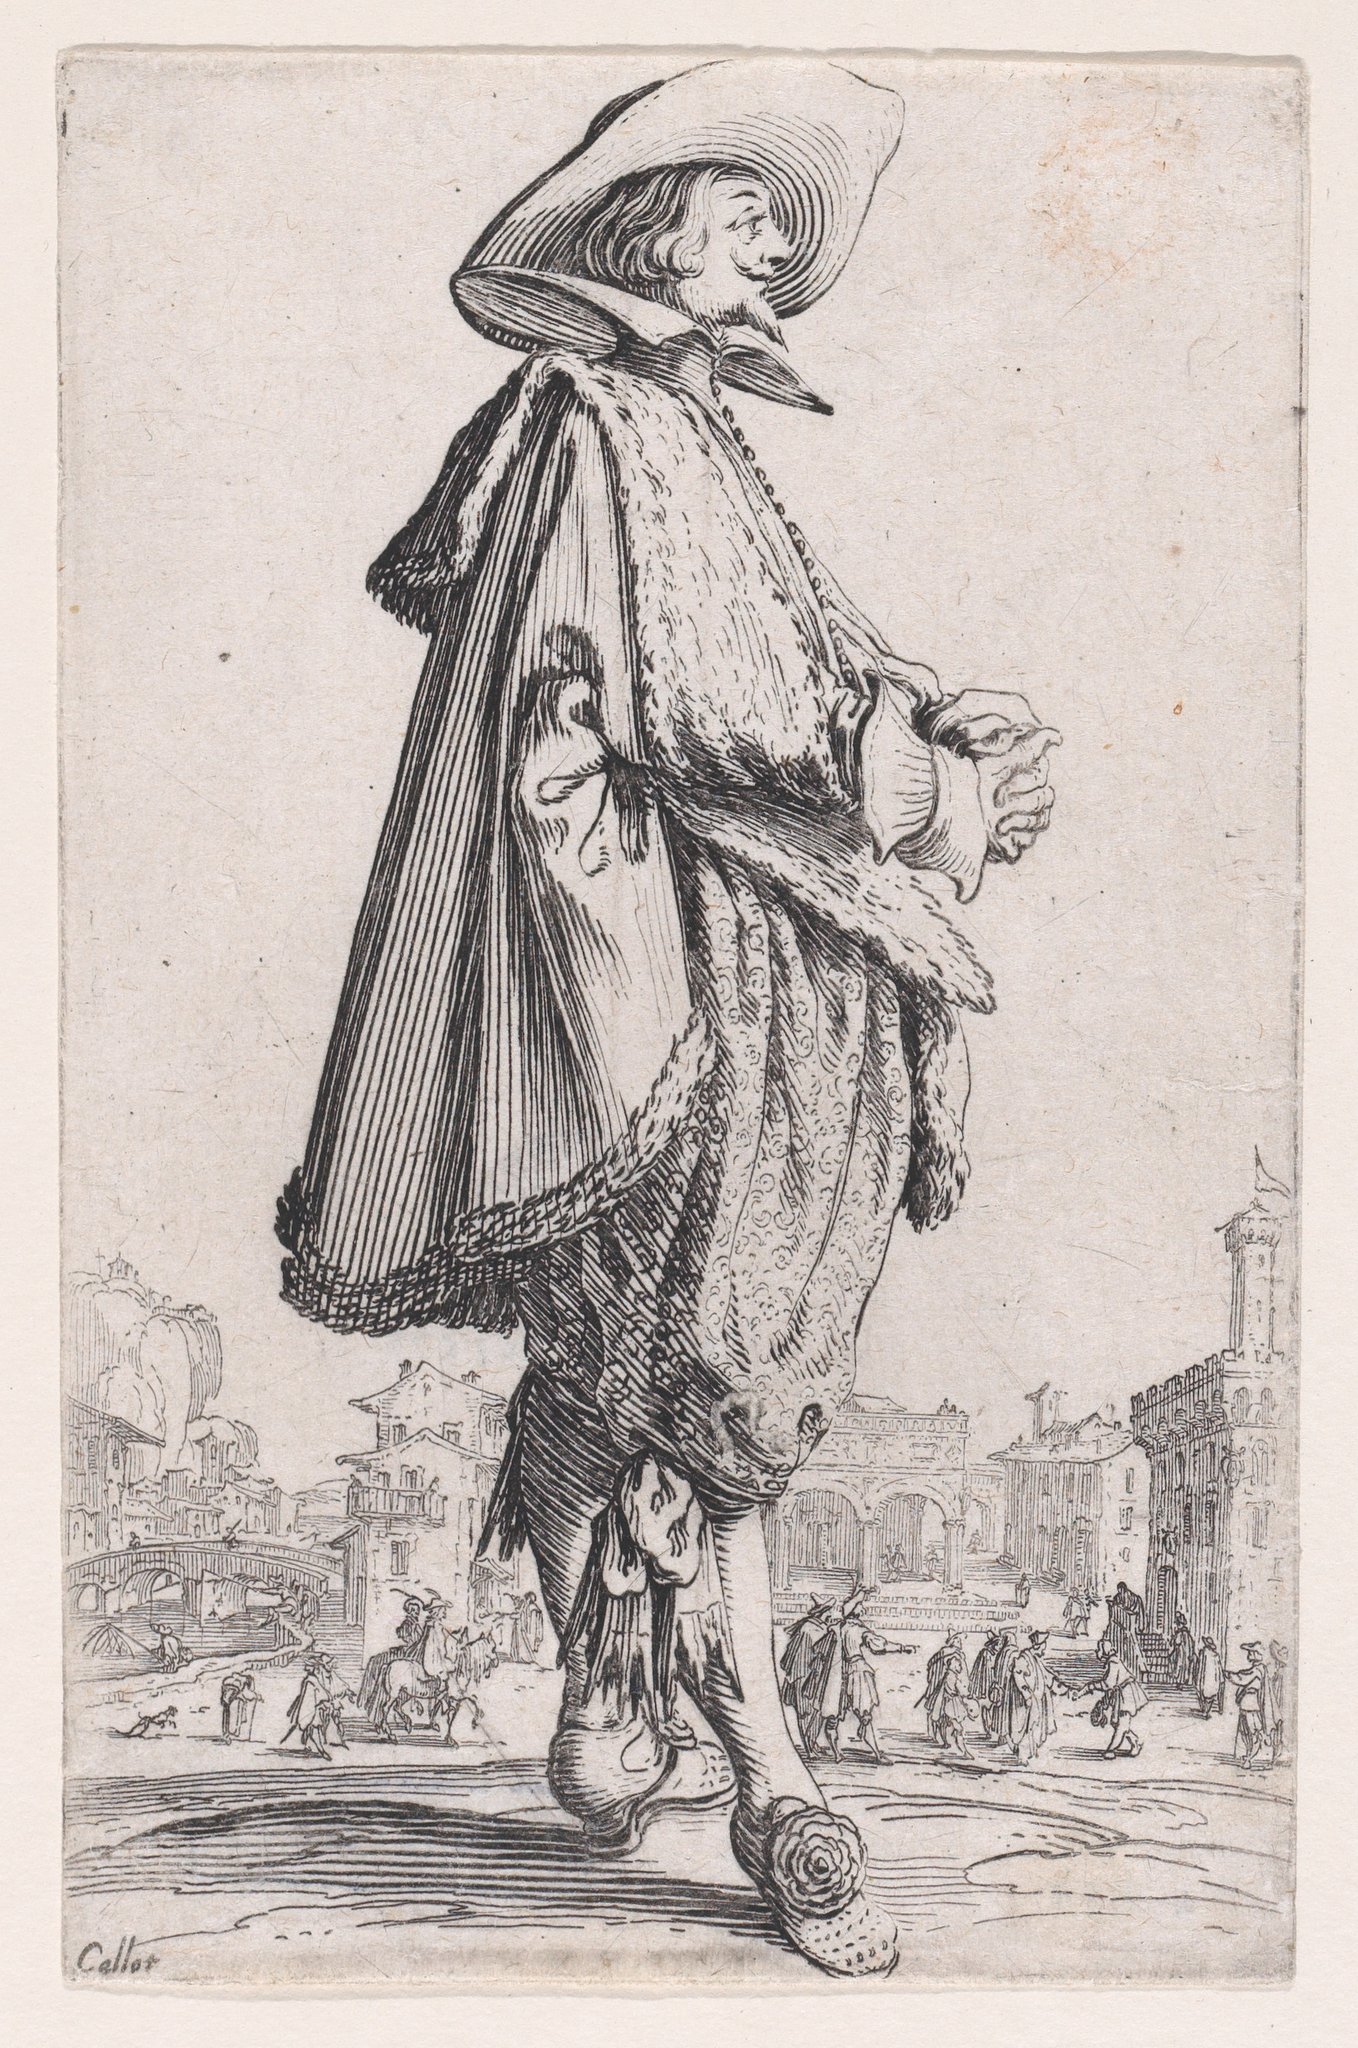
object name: print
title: Le Gentilhomme aux Mains Jointes (The Gentleman with his Hands Joined), from "La Noblesse" (The Nobility)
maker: jacques callot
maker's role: artist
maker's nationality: french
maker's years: 1592-1635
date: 1623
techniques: etching